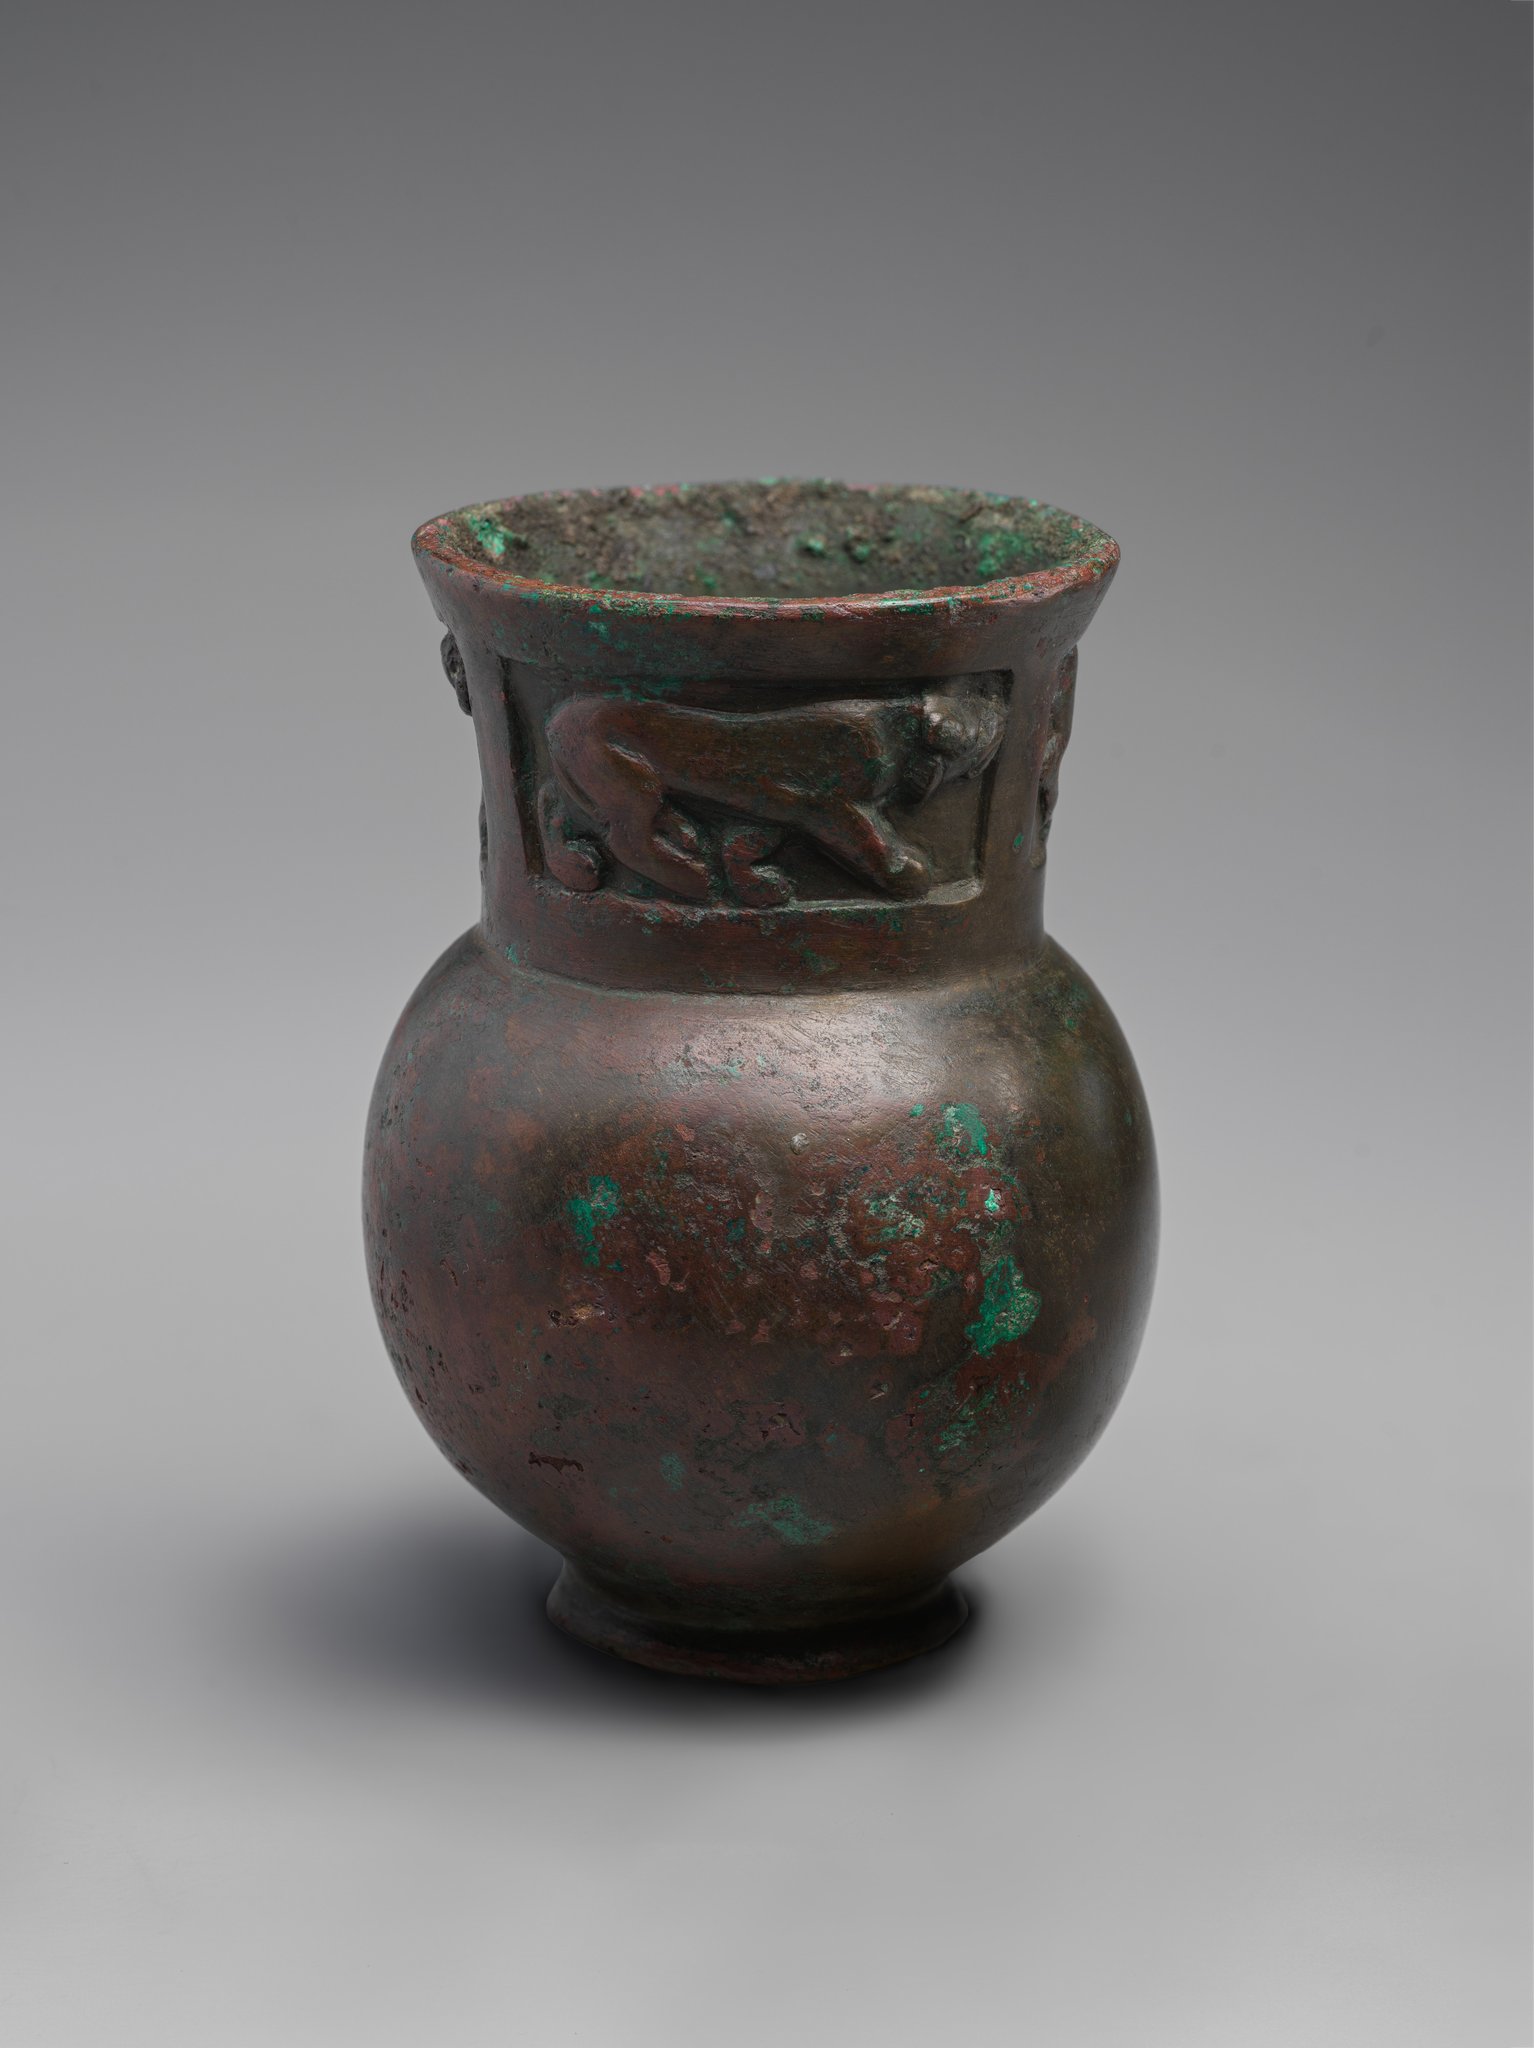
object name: jar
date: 1-1000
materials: bronze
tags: animals